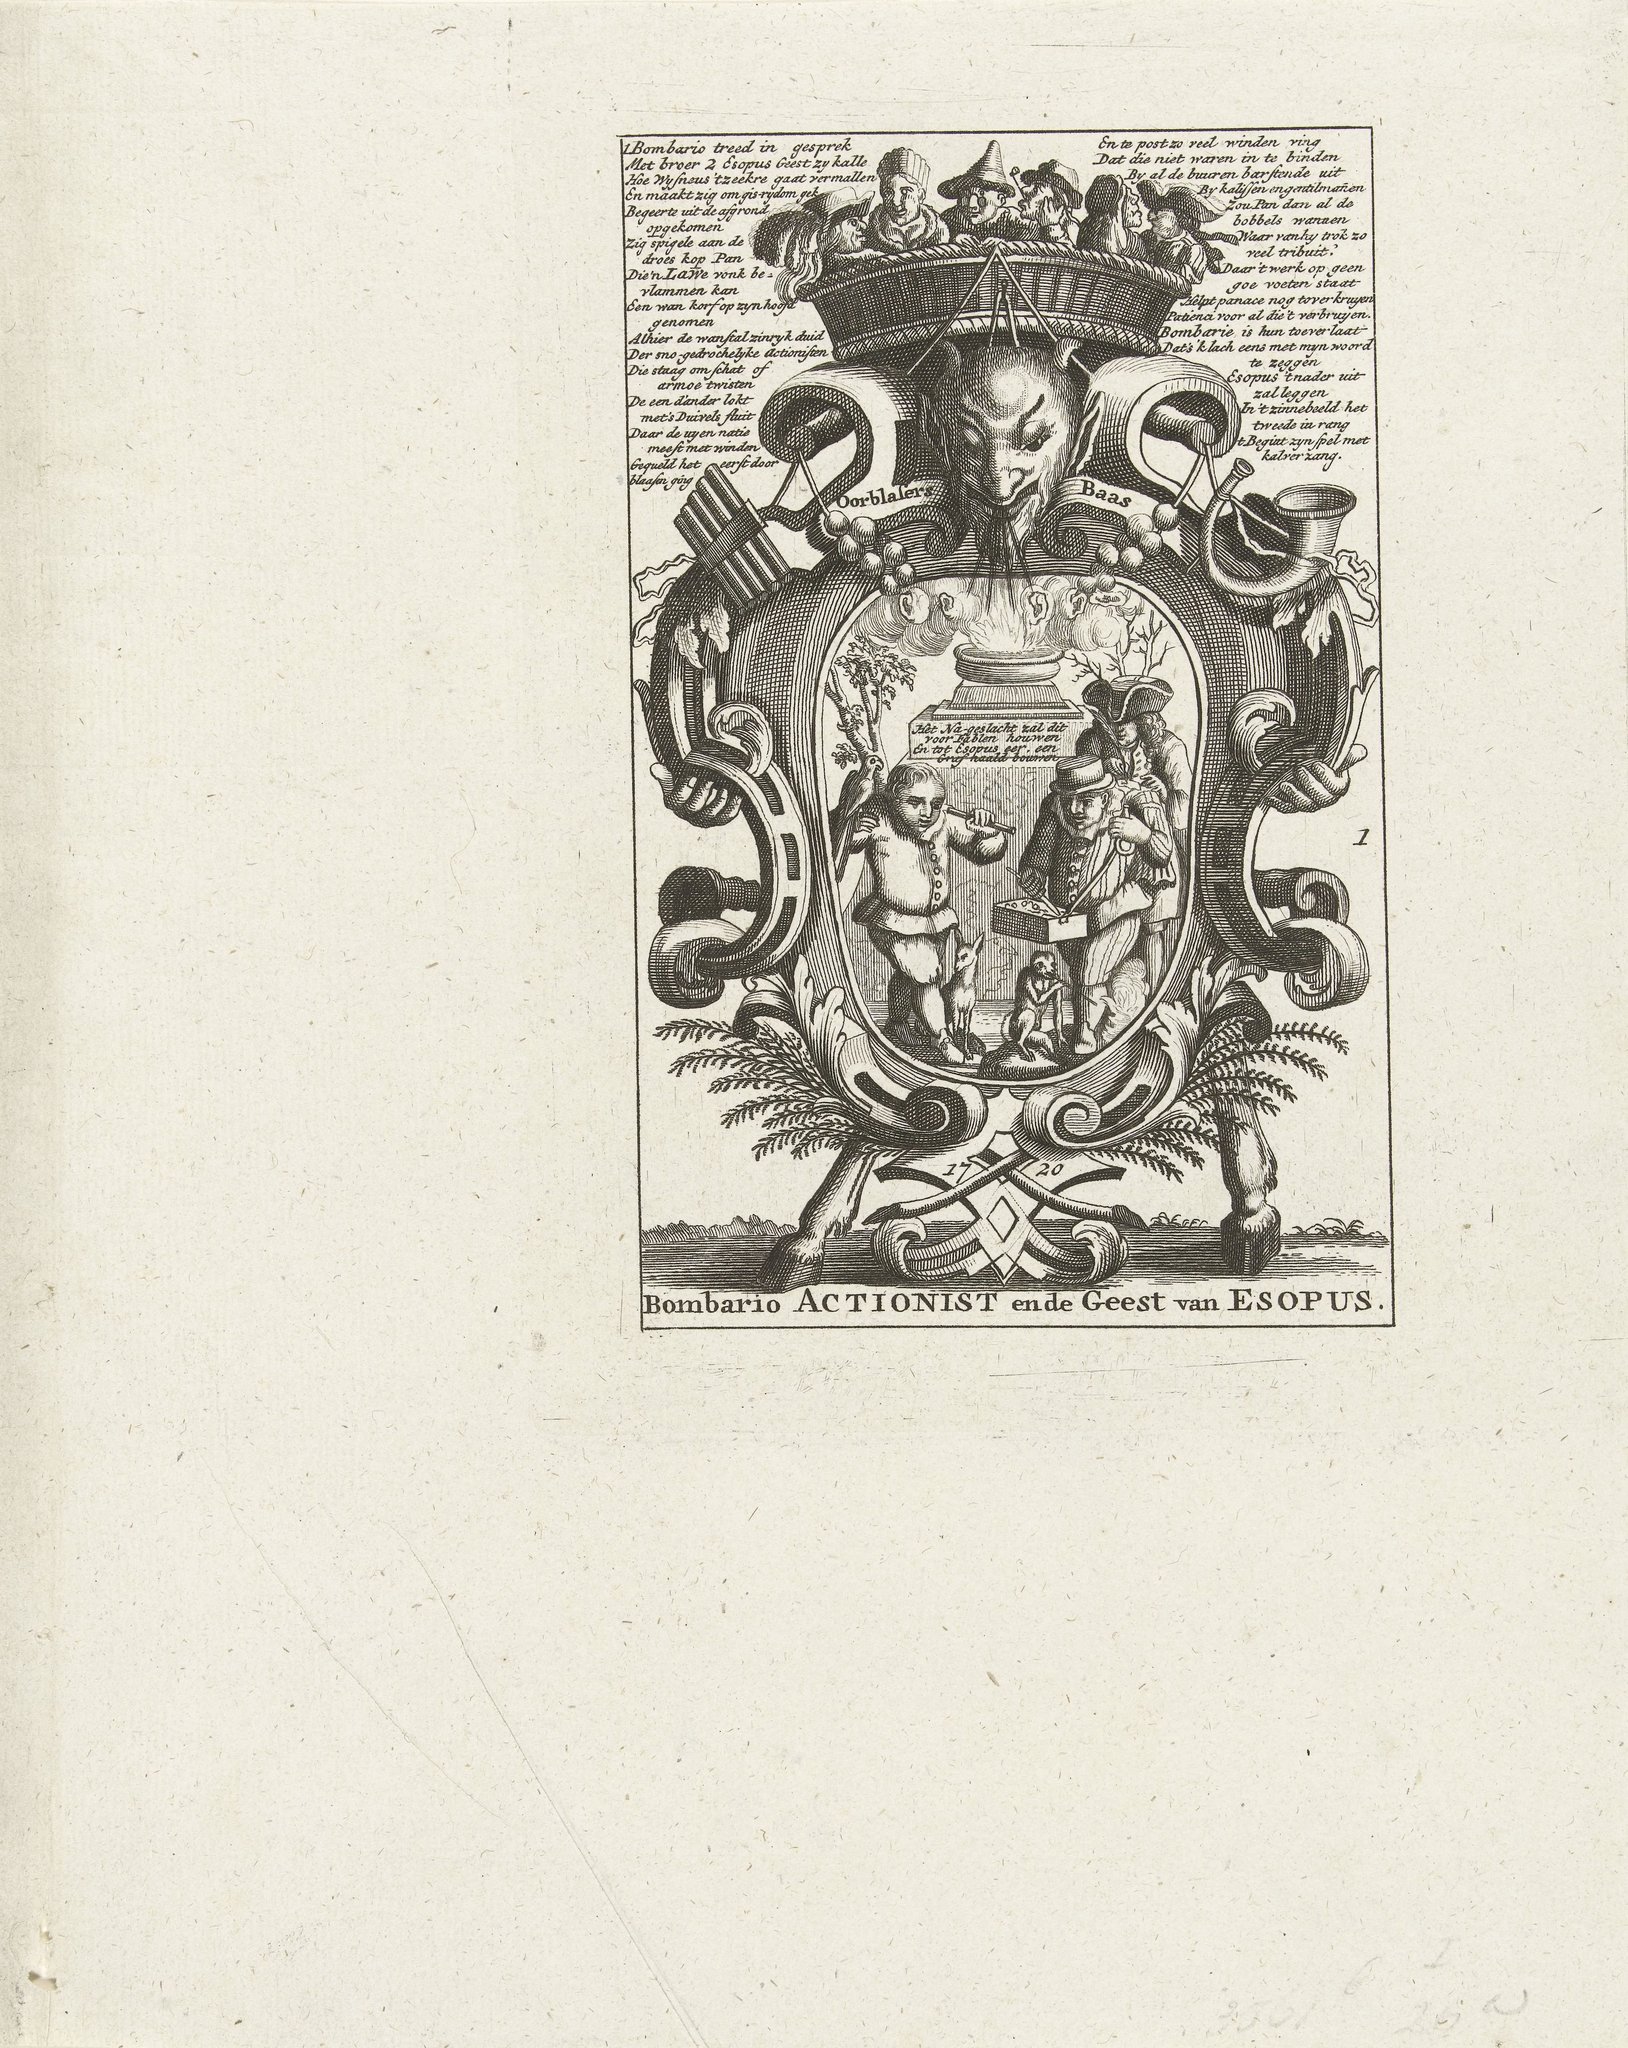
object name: print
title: Het Groote Tafereel der Dwaasheid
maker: Anonymous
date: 1770-1780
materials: paper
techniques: engraving, etching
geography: northern netherlands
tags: little people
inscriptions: collector's mark: Lugt 2228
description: Embleem over de windhandel met Bombario in een omlijsting met de duivel en bokkenpoten, bekroond door een mand vol dwazen. Genummerd 1. Gedrukt van een grote plaat waarop alle vier voorstellingen genummerd 1-4 zijn geëtst. Prent 26/1 in de serie Het Groote Tafereel der Dwaasheid met spotprenten op de Windhandel of Actiehandel van 1720.